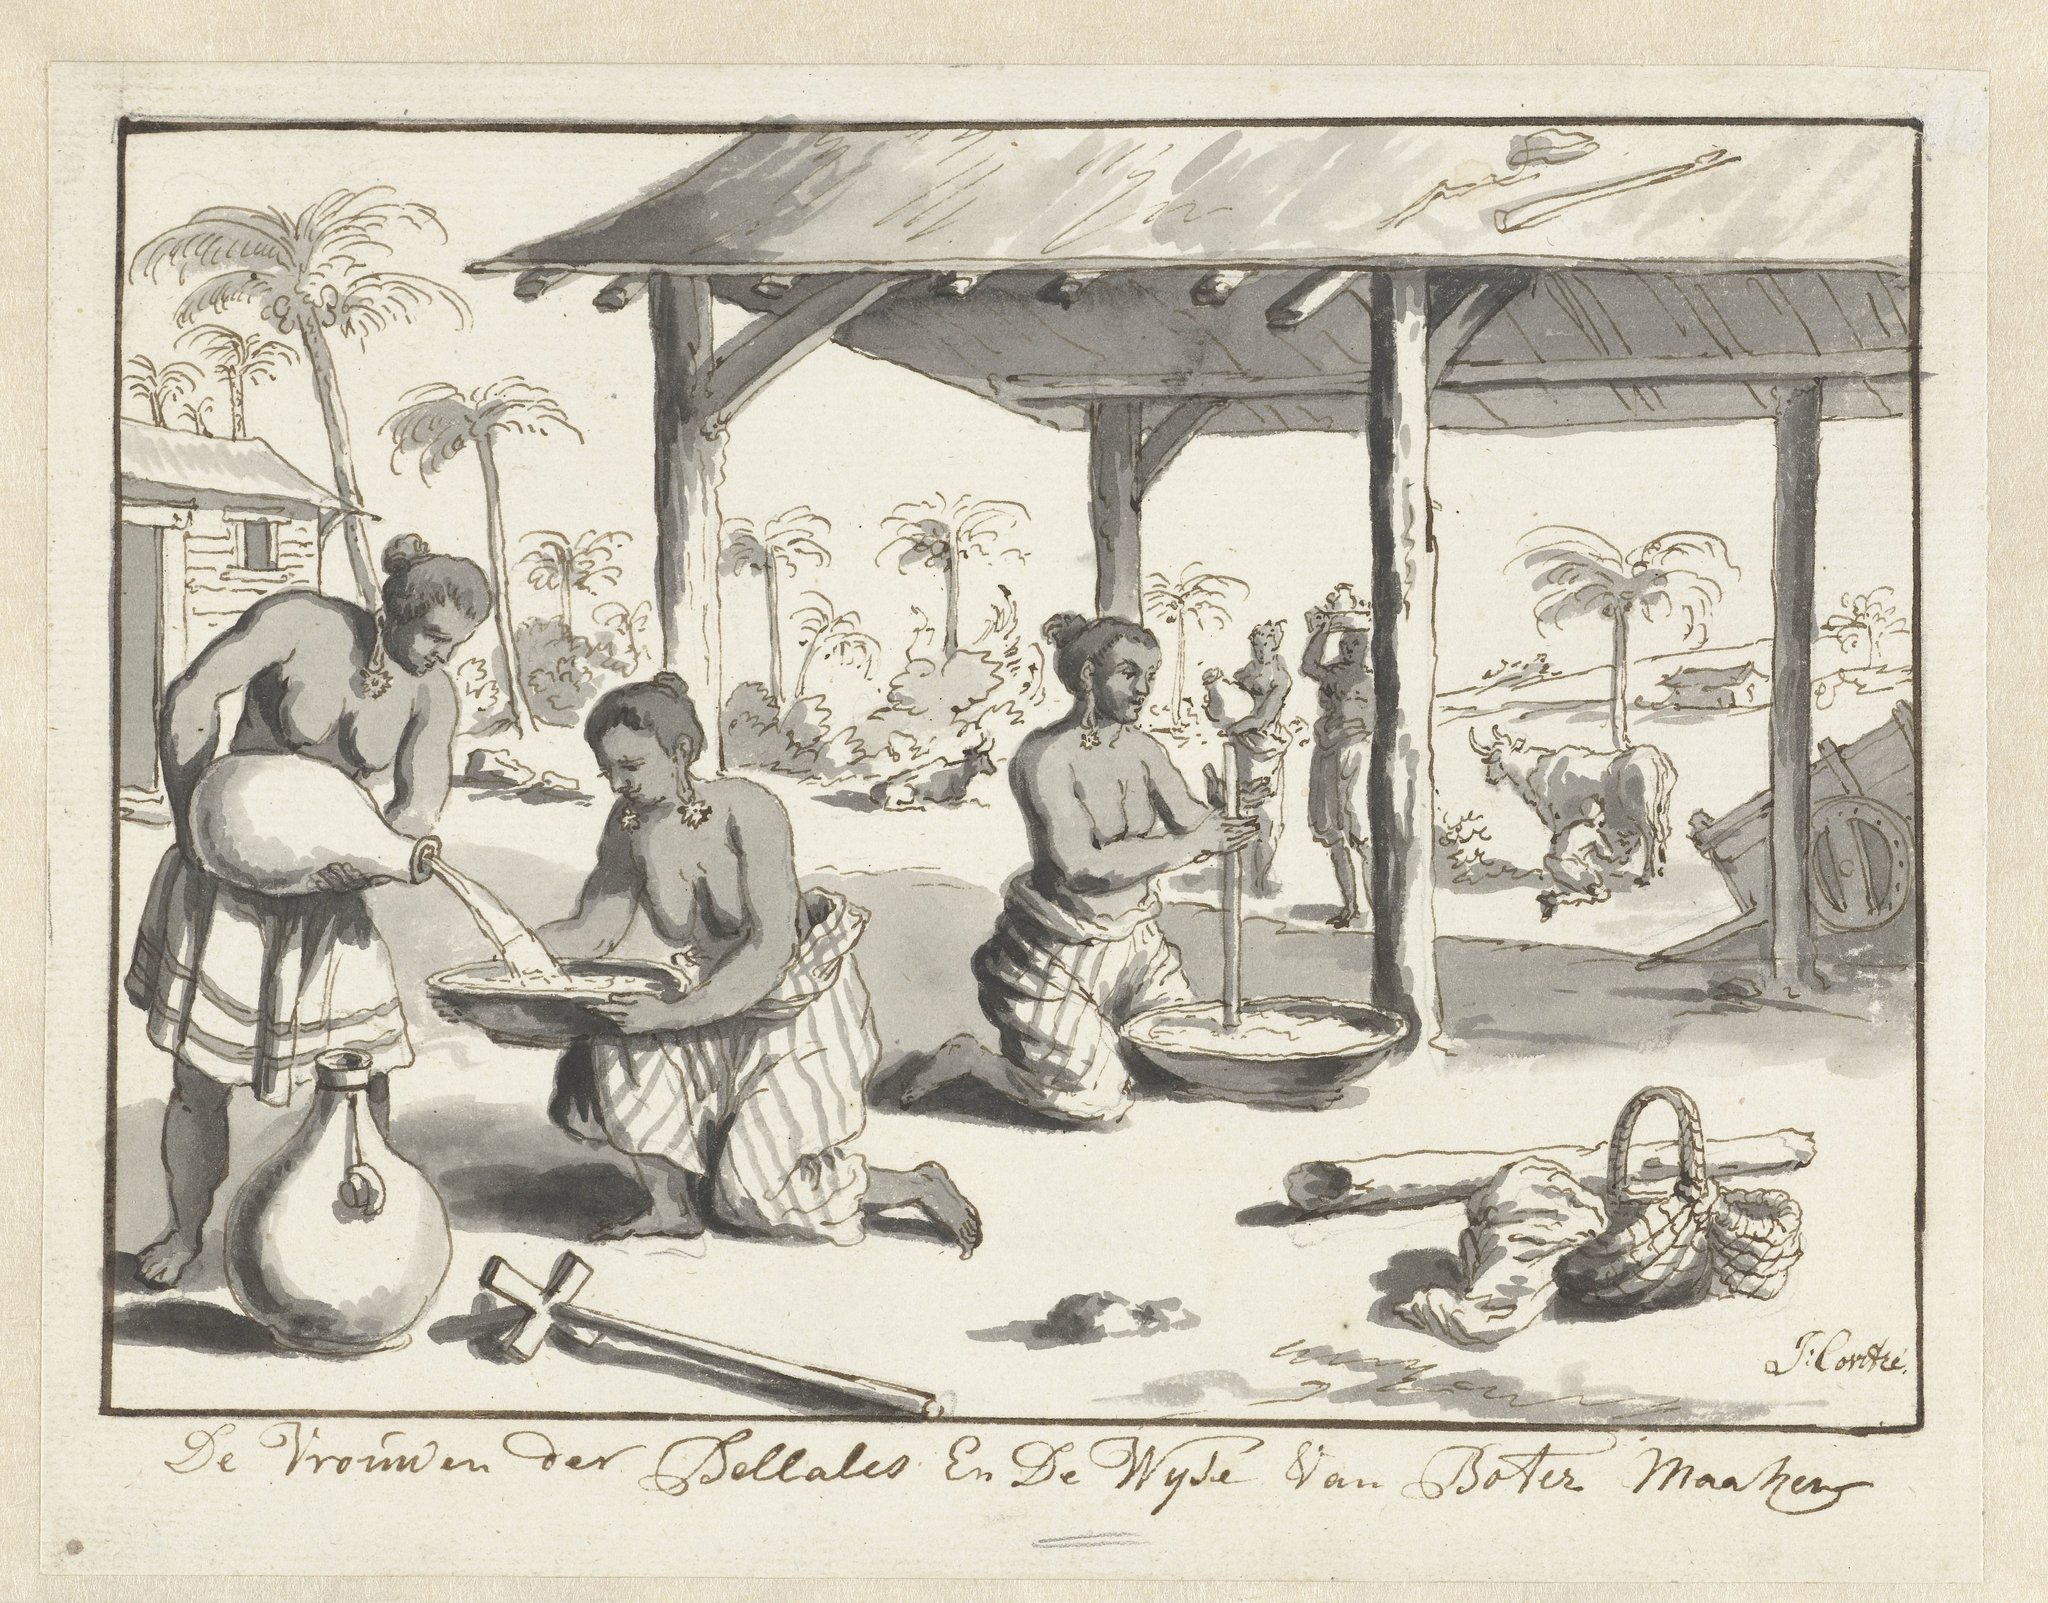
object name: drawing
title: Vrouwen van de stam der Bellales op Ceylon maken boter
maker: jean covitré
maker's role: draughtsman, print maker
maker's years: 1734-1765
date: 1744-1765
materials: ink, paper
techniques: brush, pen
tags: asiatic races and peoples, sri lanka